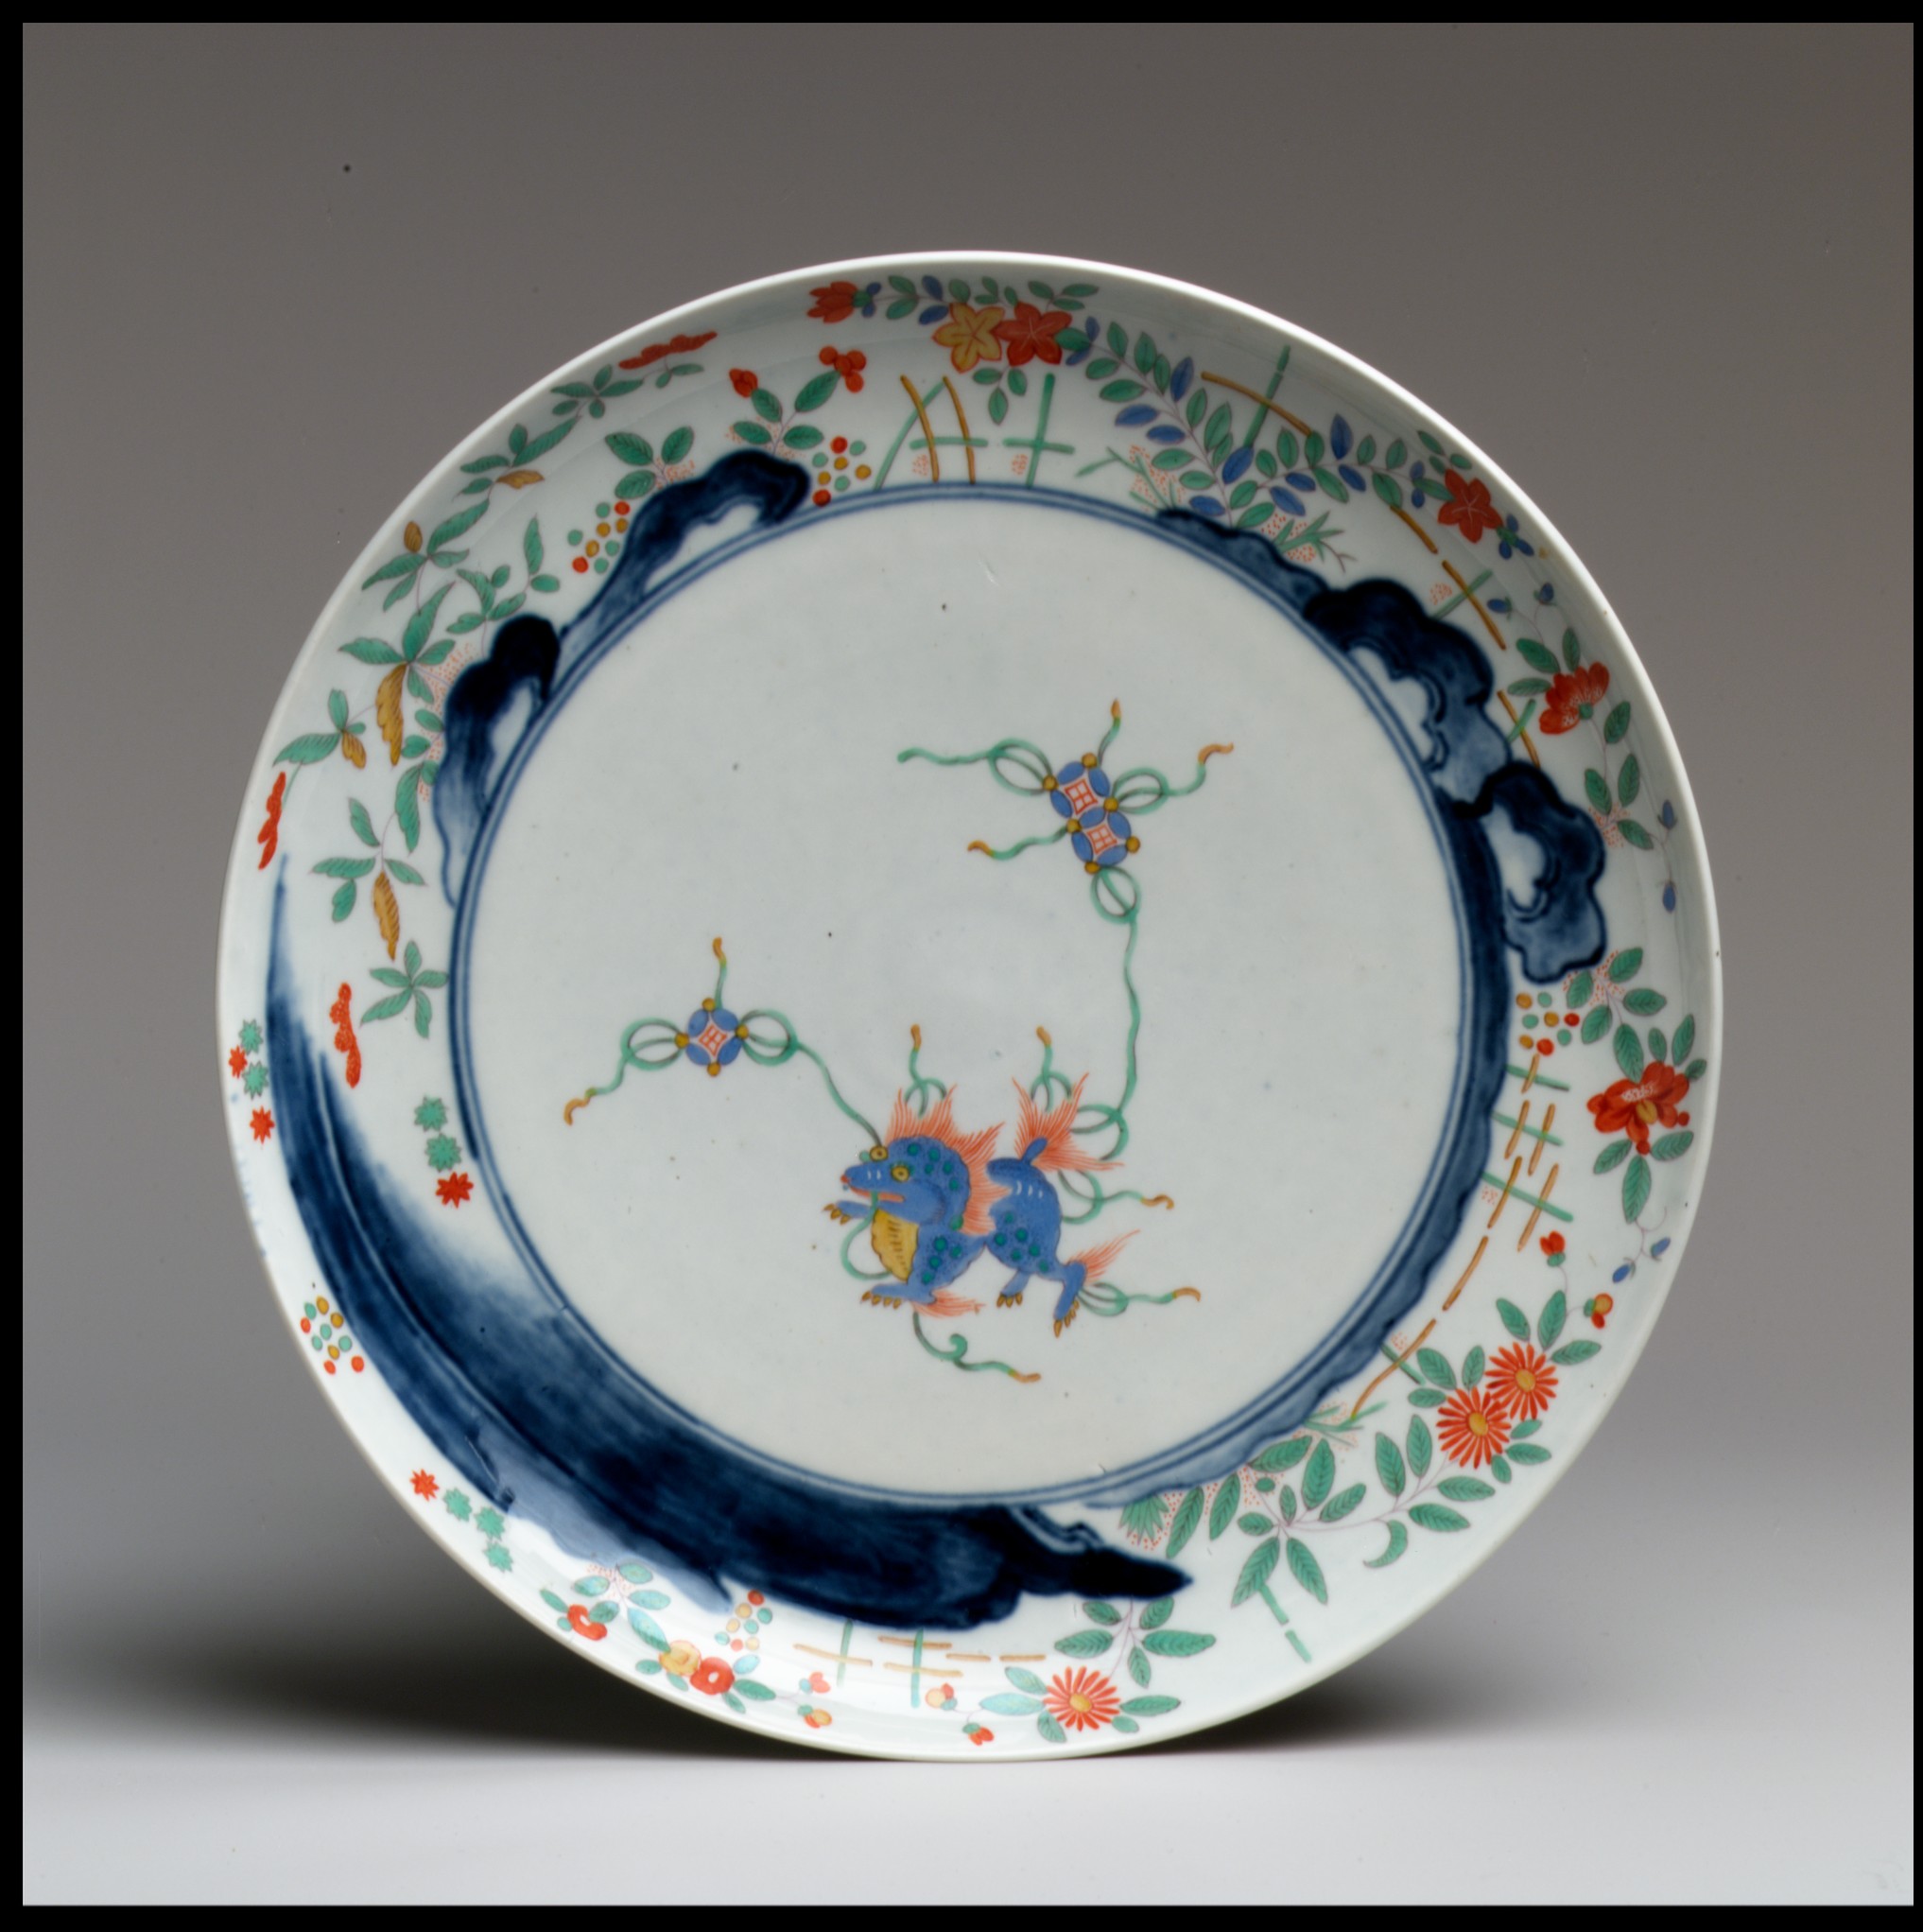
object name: plate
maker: imperial porcelain manufactory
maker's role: manufactory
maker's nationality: austrian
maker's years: 1744-1864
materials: hard paste porcelain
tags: mythical creatures